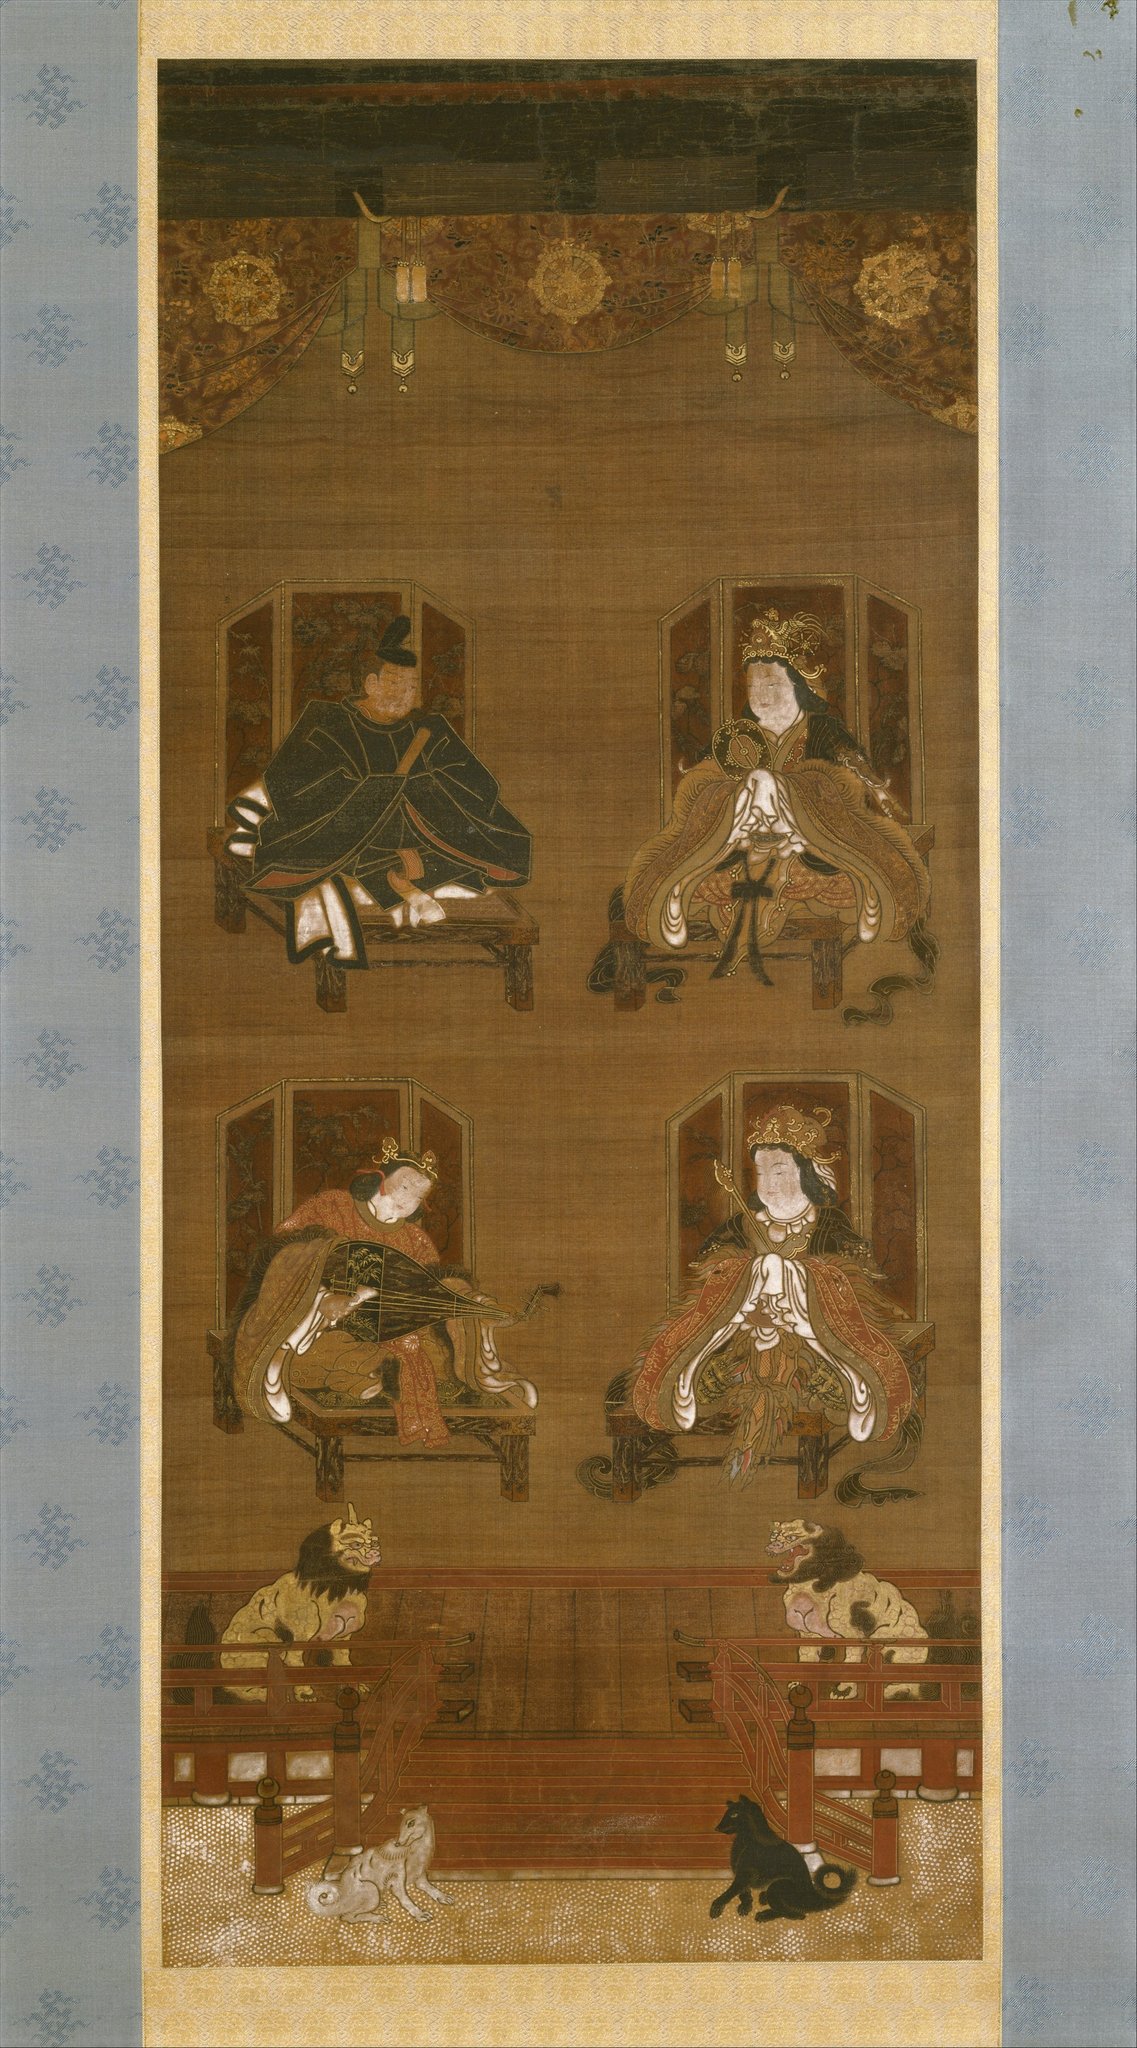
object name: hanging scroll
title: The Four Deities of Mount Kōya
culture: japanese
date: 1367-1400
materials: gold, ink, silk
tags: dogs,lions,deities